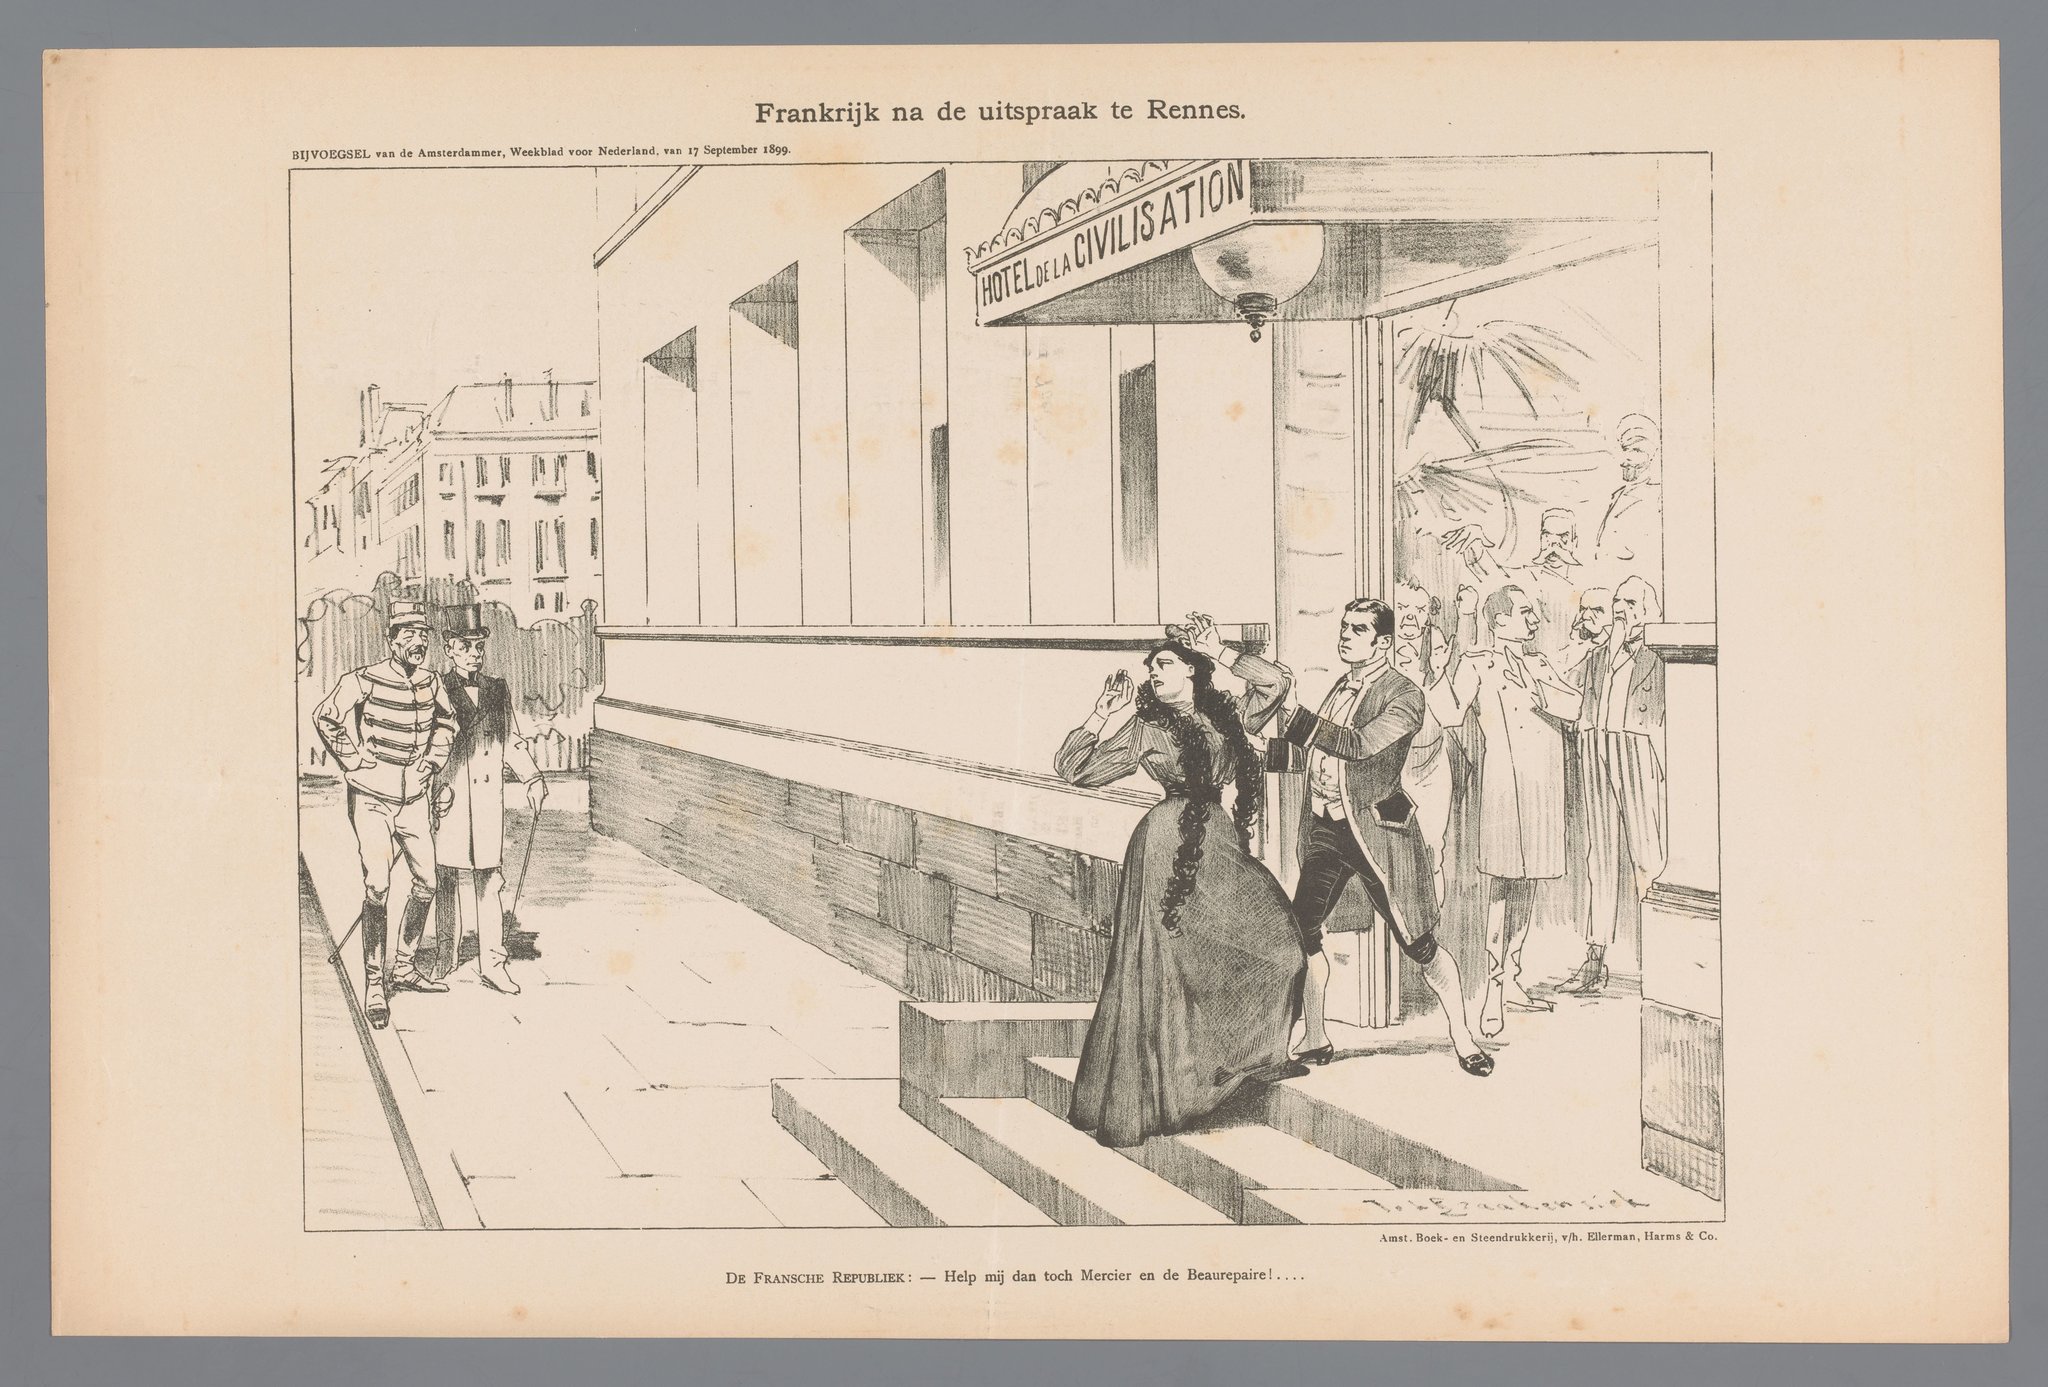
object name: cartoon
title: Frankrijk na de uitspraak te Rennes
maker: johan braakensiek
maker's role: draughtsman, print maker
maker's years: 1858-1940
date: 1899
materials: paper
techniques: lithograph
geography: amsterdam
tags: political caricatures and satires, france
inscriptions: date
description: Prent uit het bijvoegsel van: De Amsterdammer. Weekblad voor Nederland, 17 september 1899.